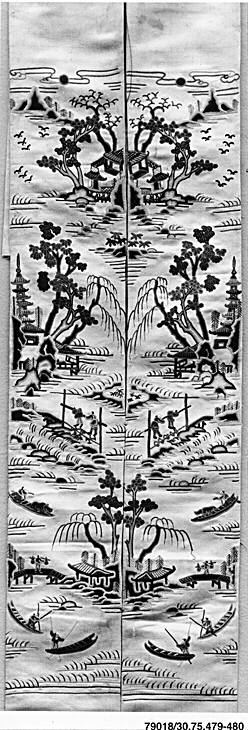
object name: sleeve band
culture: chinese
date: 1801-1900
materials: silk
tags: houses,trees